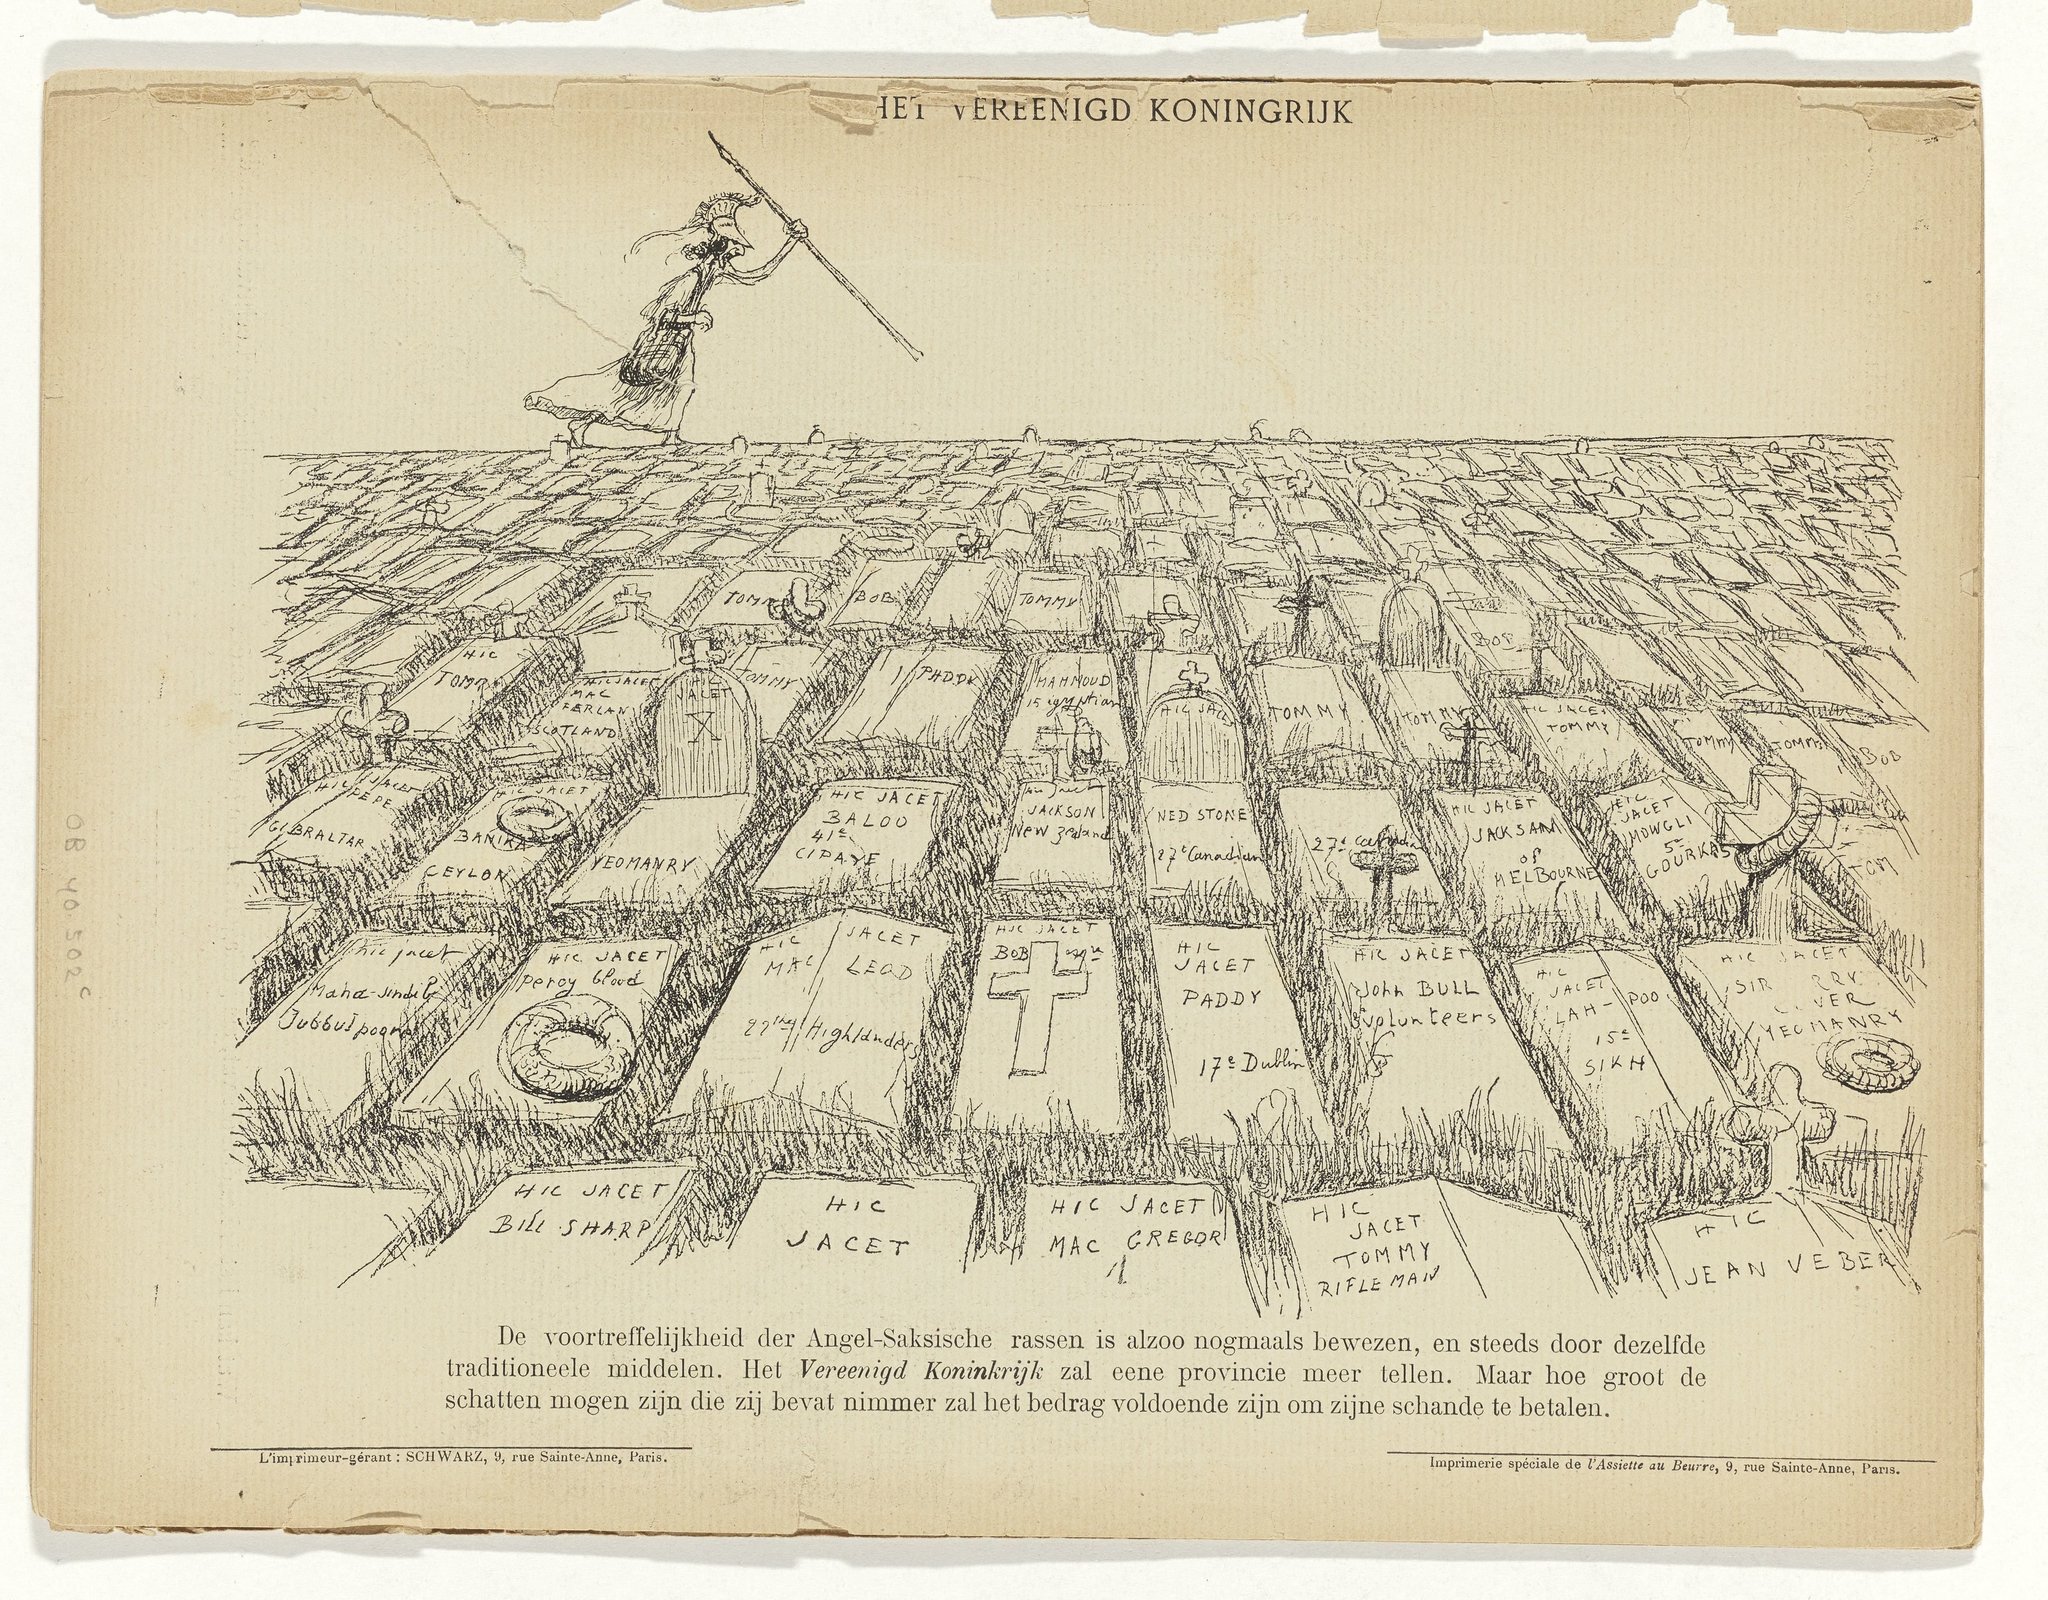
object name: cartoon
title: Het Vereenigd Koningrijk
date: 1901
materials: paper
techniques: letterpress printing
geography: amsterdam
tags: gravestone, tombstone, symbols, allegories of war; 'guerra' (ripa), political caricatures and satires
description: Prent maakt deel uit van een tijdschrift met spotprenten op de Tweede Boerenoorlog. Met drieregelig onderschrift: De voortreffelijkheid der Angel-Saksische rassen is alzoo nogmaals bewezen ... nimmer zal het bedrag voldoende zijn om zijne schande te betalen.